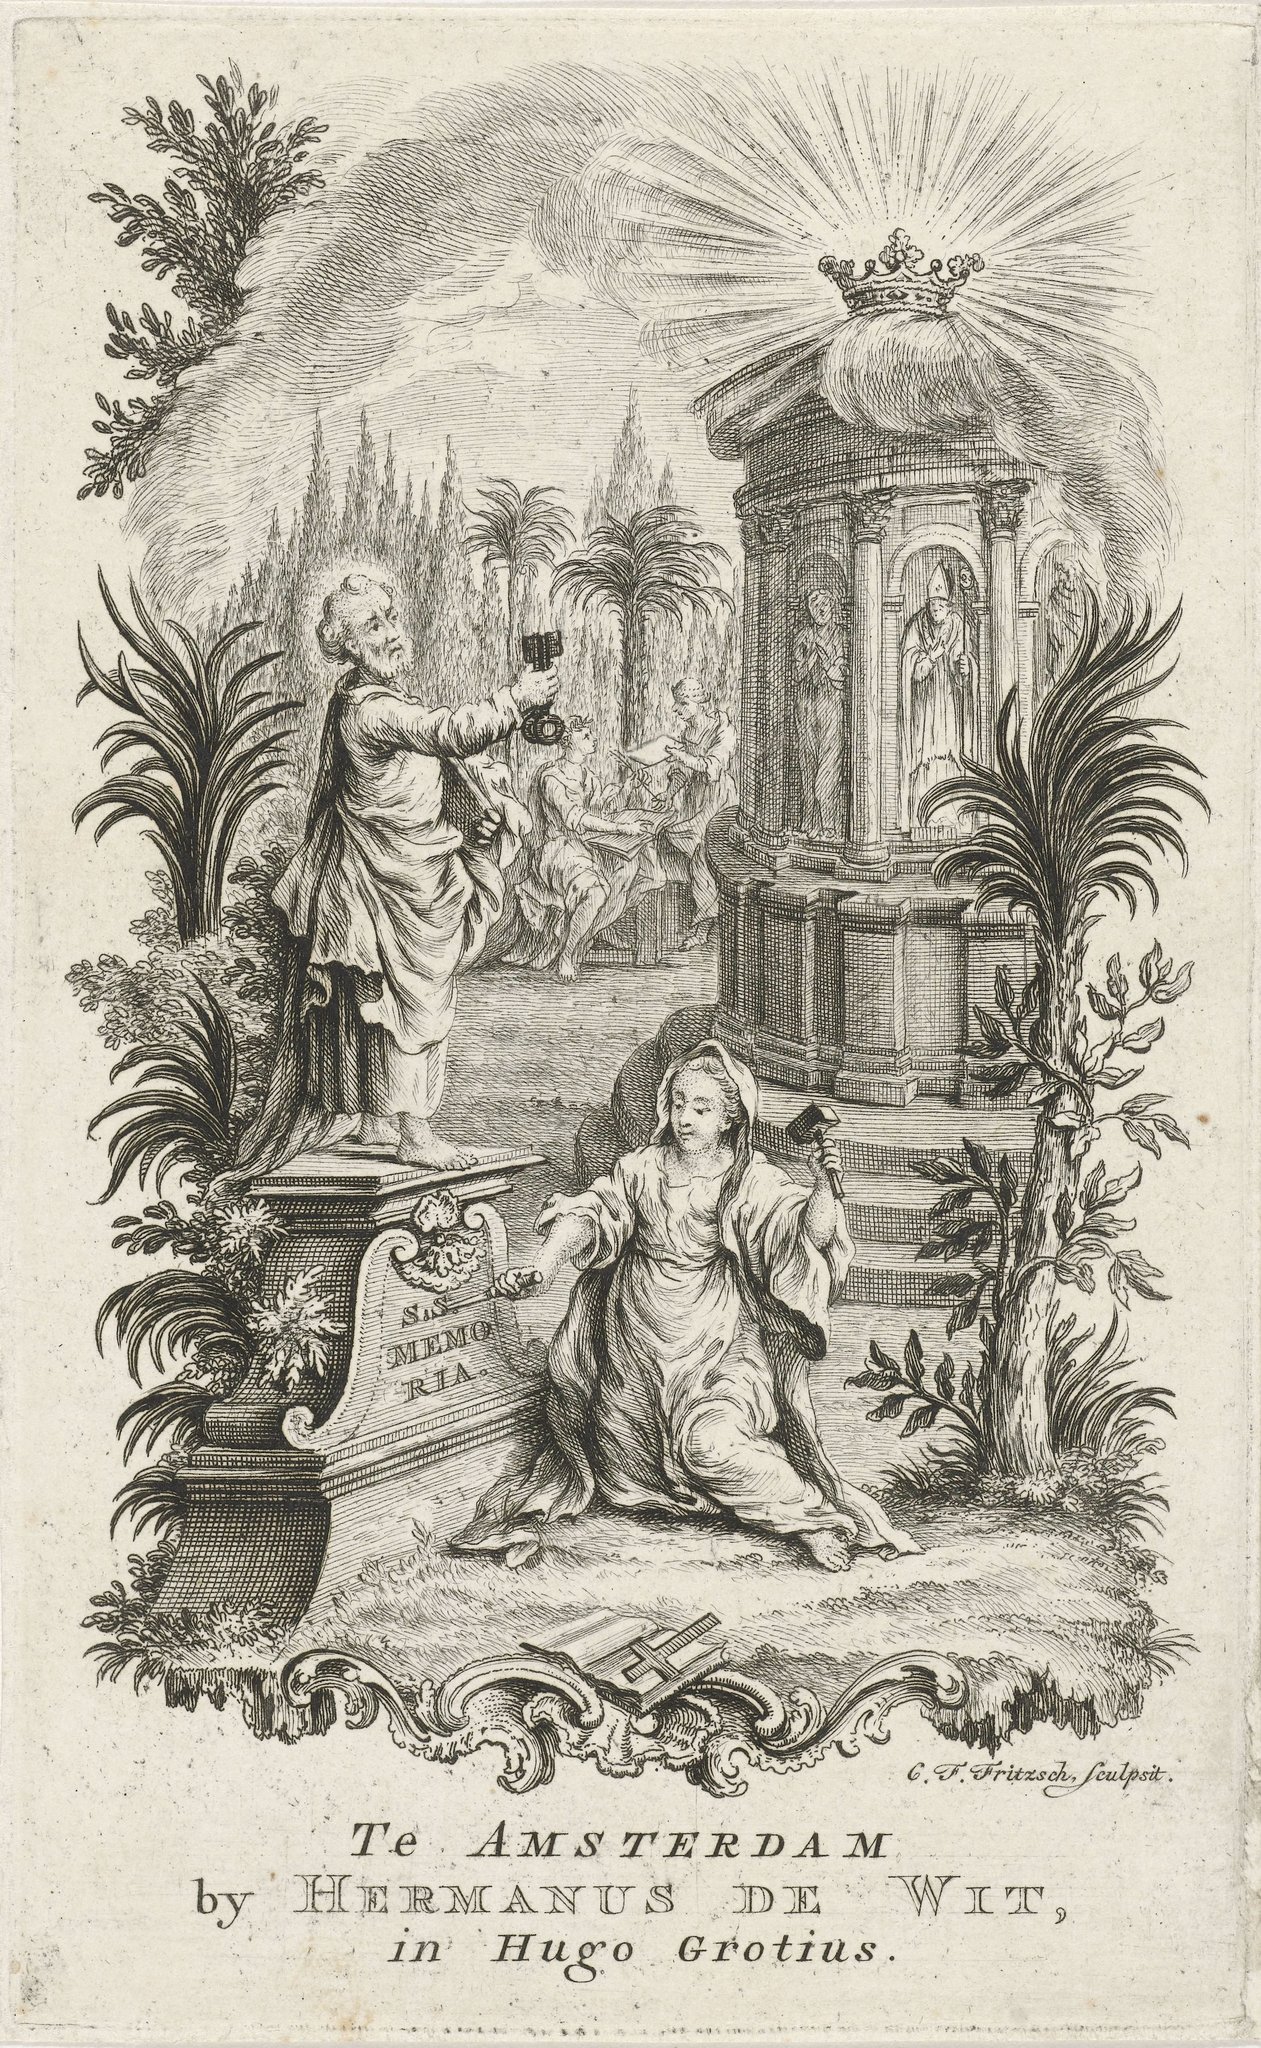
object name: print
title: Petrus met de sleutel van het Koninkrijk der Hemelen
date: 1742-1770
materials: paper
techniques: etching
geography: amsterdam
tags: the apostle peter, first bishop of rome; possible attributes: book, cock, (upturned) cross, (triple) crozier, fish, key, scroll, ship, tiara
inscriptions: collector's mark: Lugt 240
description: Titelpagina met allegorische voorstelling van Petrus. Links staat Petrus op een voetstuk met de sleutel van het Koninkrijk der Hemelen in zijn hand. Een gesluierde vrouw is neergeknield bij het voetstuk om er een opschrift in te beitelen. Rechts in de verte staat een tempel waar in nissen beelden zijn geplaatst.